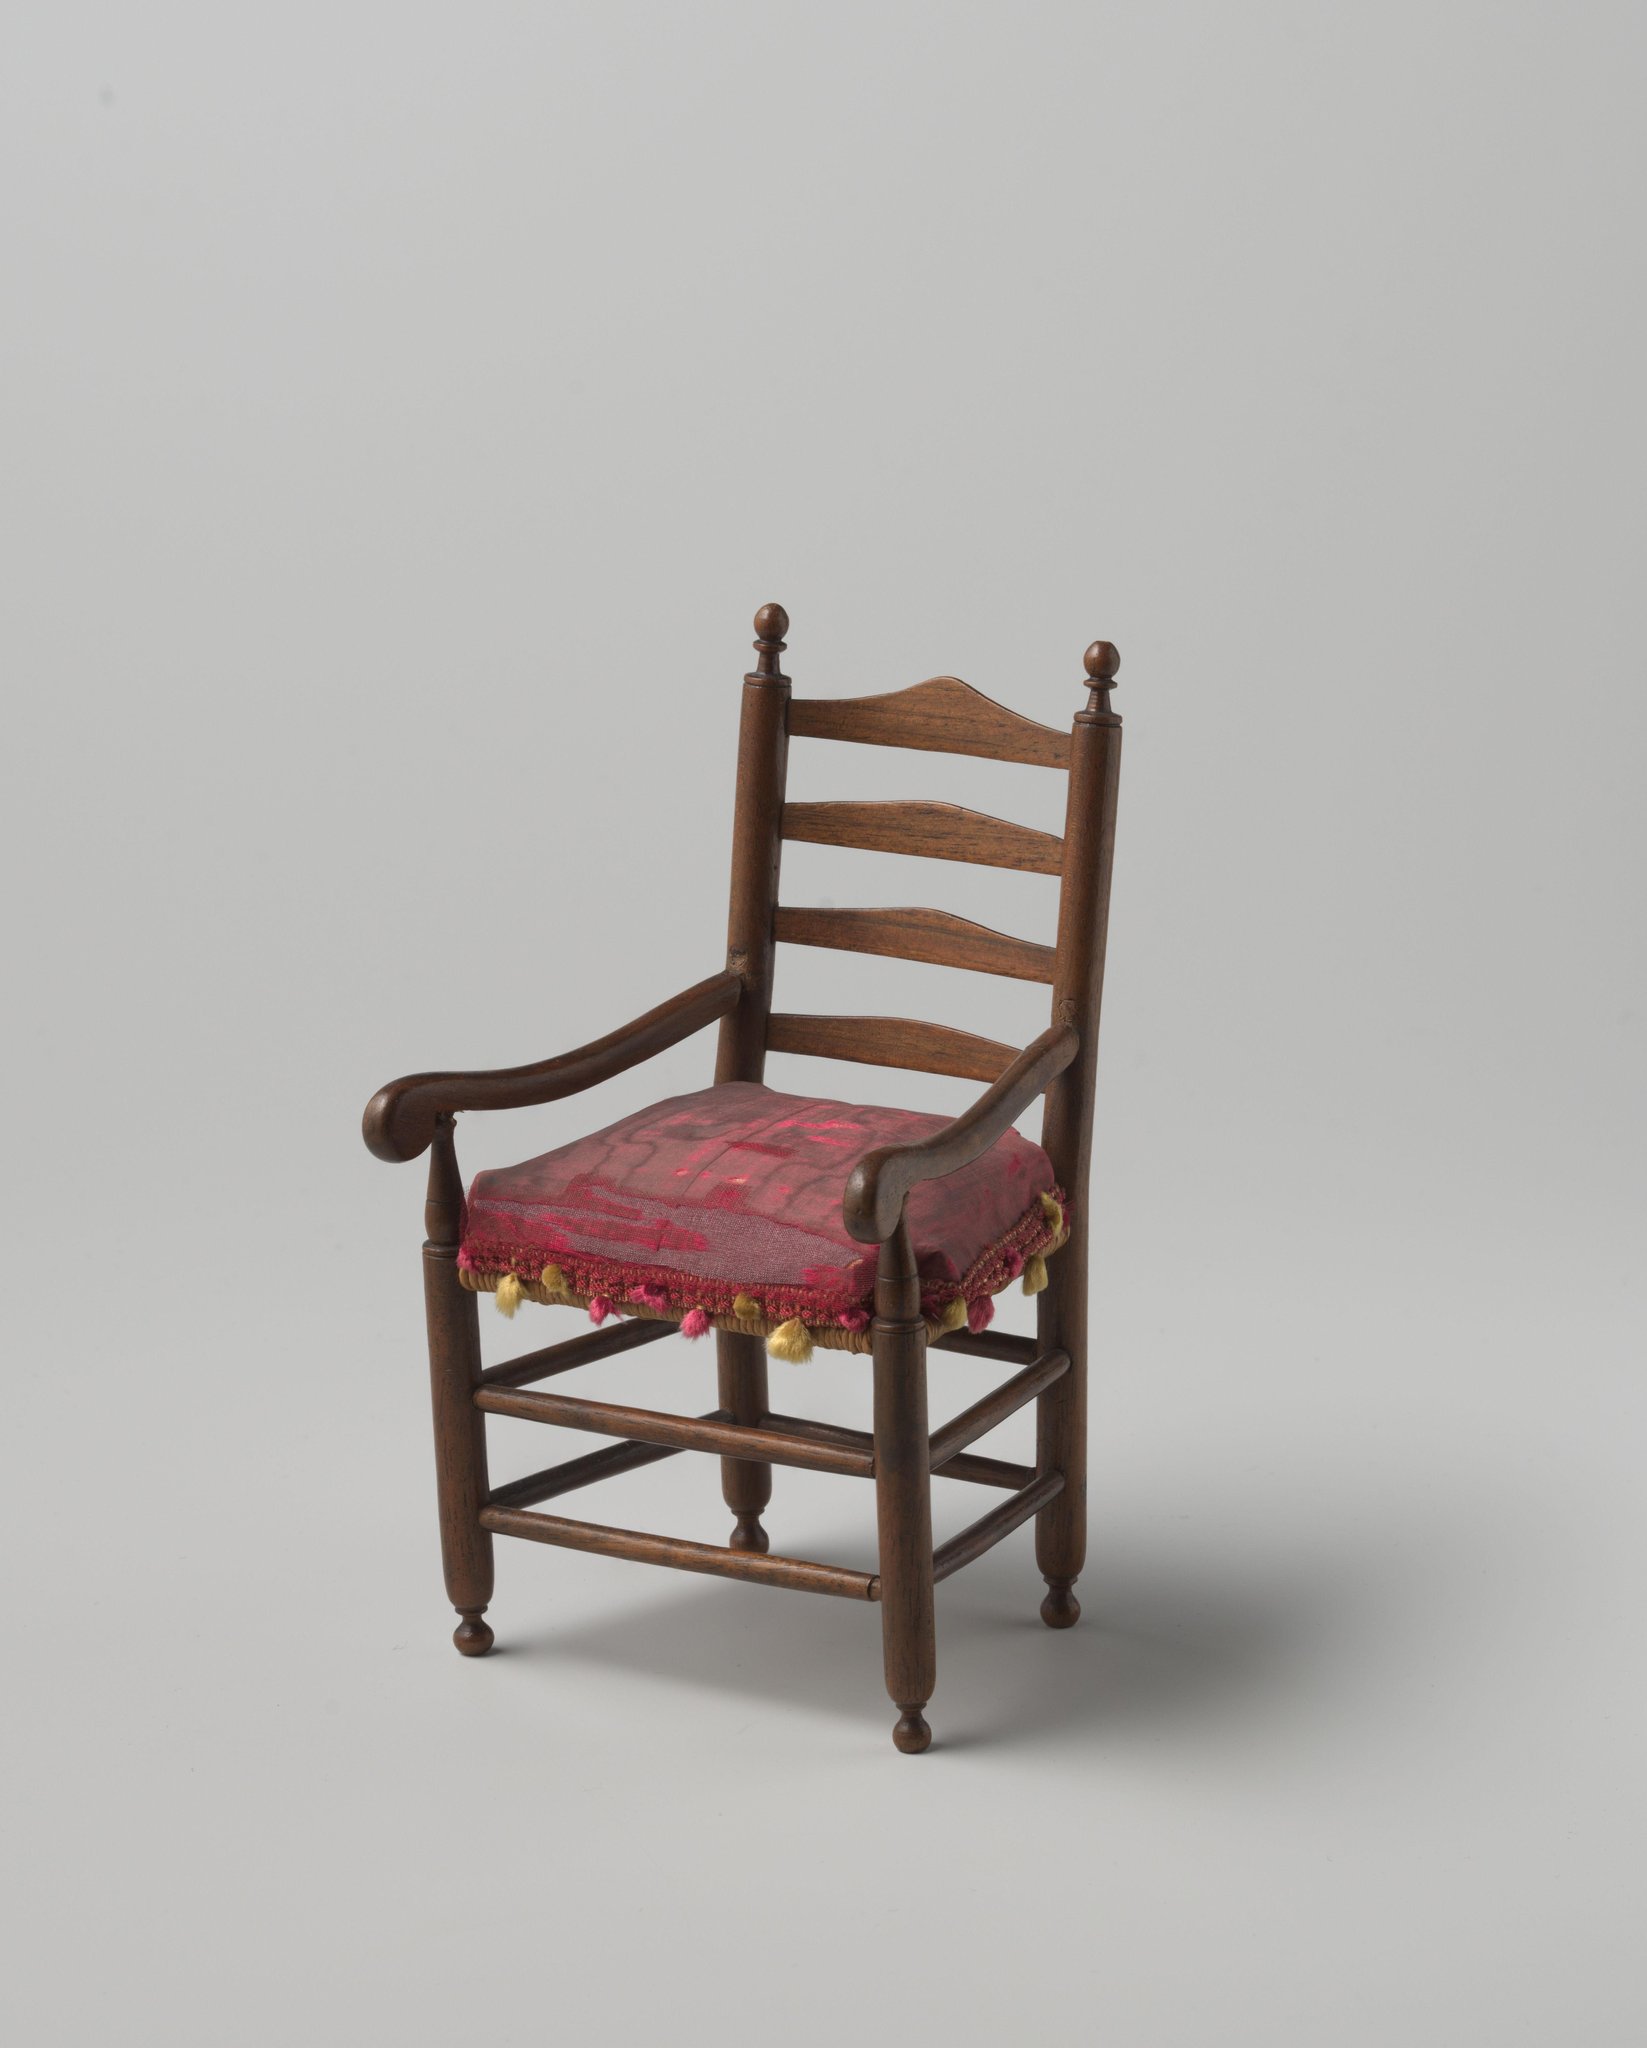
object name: miniature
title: Armstoel (model knopstoel) van notenhout met gladde, gedraaide stijlen en dwarsregels, voorpoten en achterstijlen eindigend in fijn gedraaide knoppen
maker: Anonymous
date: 1690-1710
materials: cardboard, linen, silk, fiber, wood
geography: amsterdam